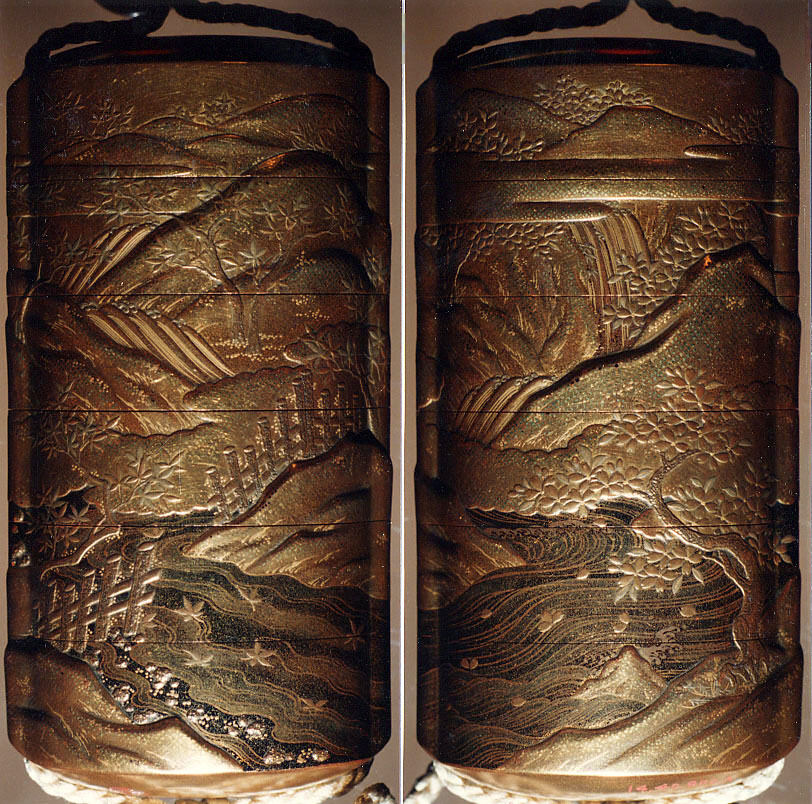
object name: inrō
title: Case (Inrō) with Design of Hilly Landscape with Maple and Cherry Trees beside a River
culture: japanese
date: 1801-1900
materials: gold, lacquer, silver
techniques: fundame, hiramakie, maki-e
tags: landscapes,trees